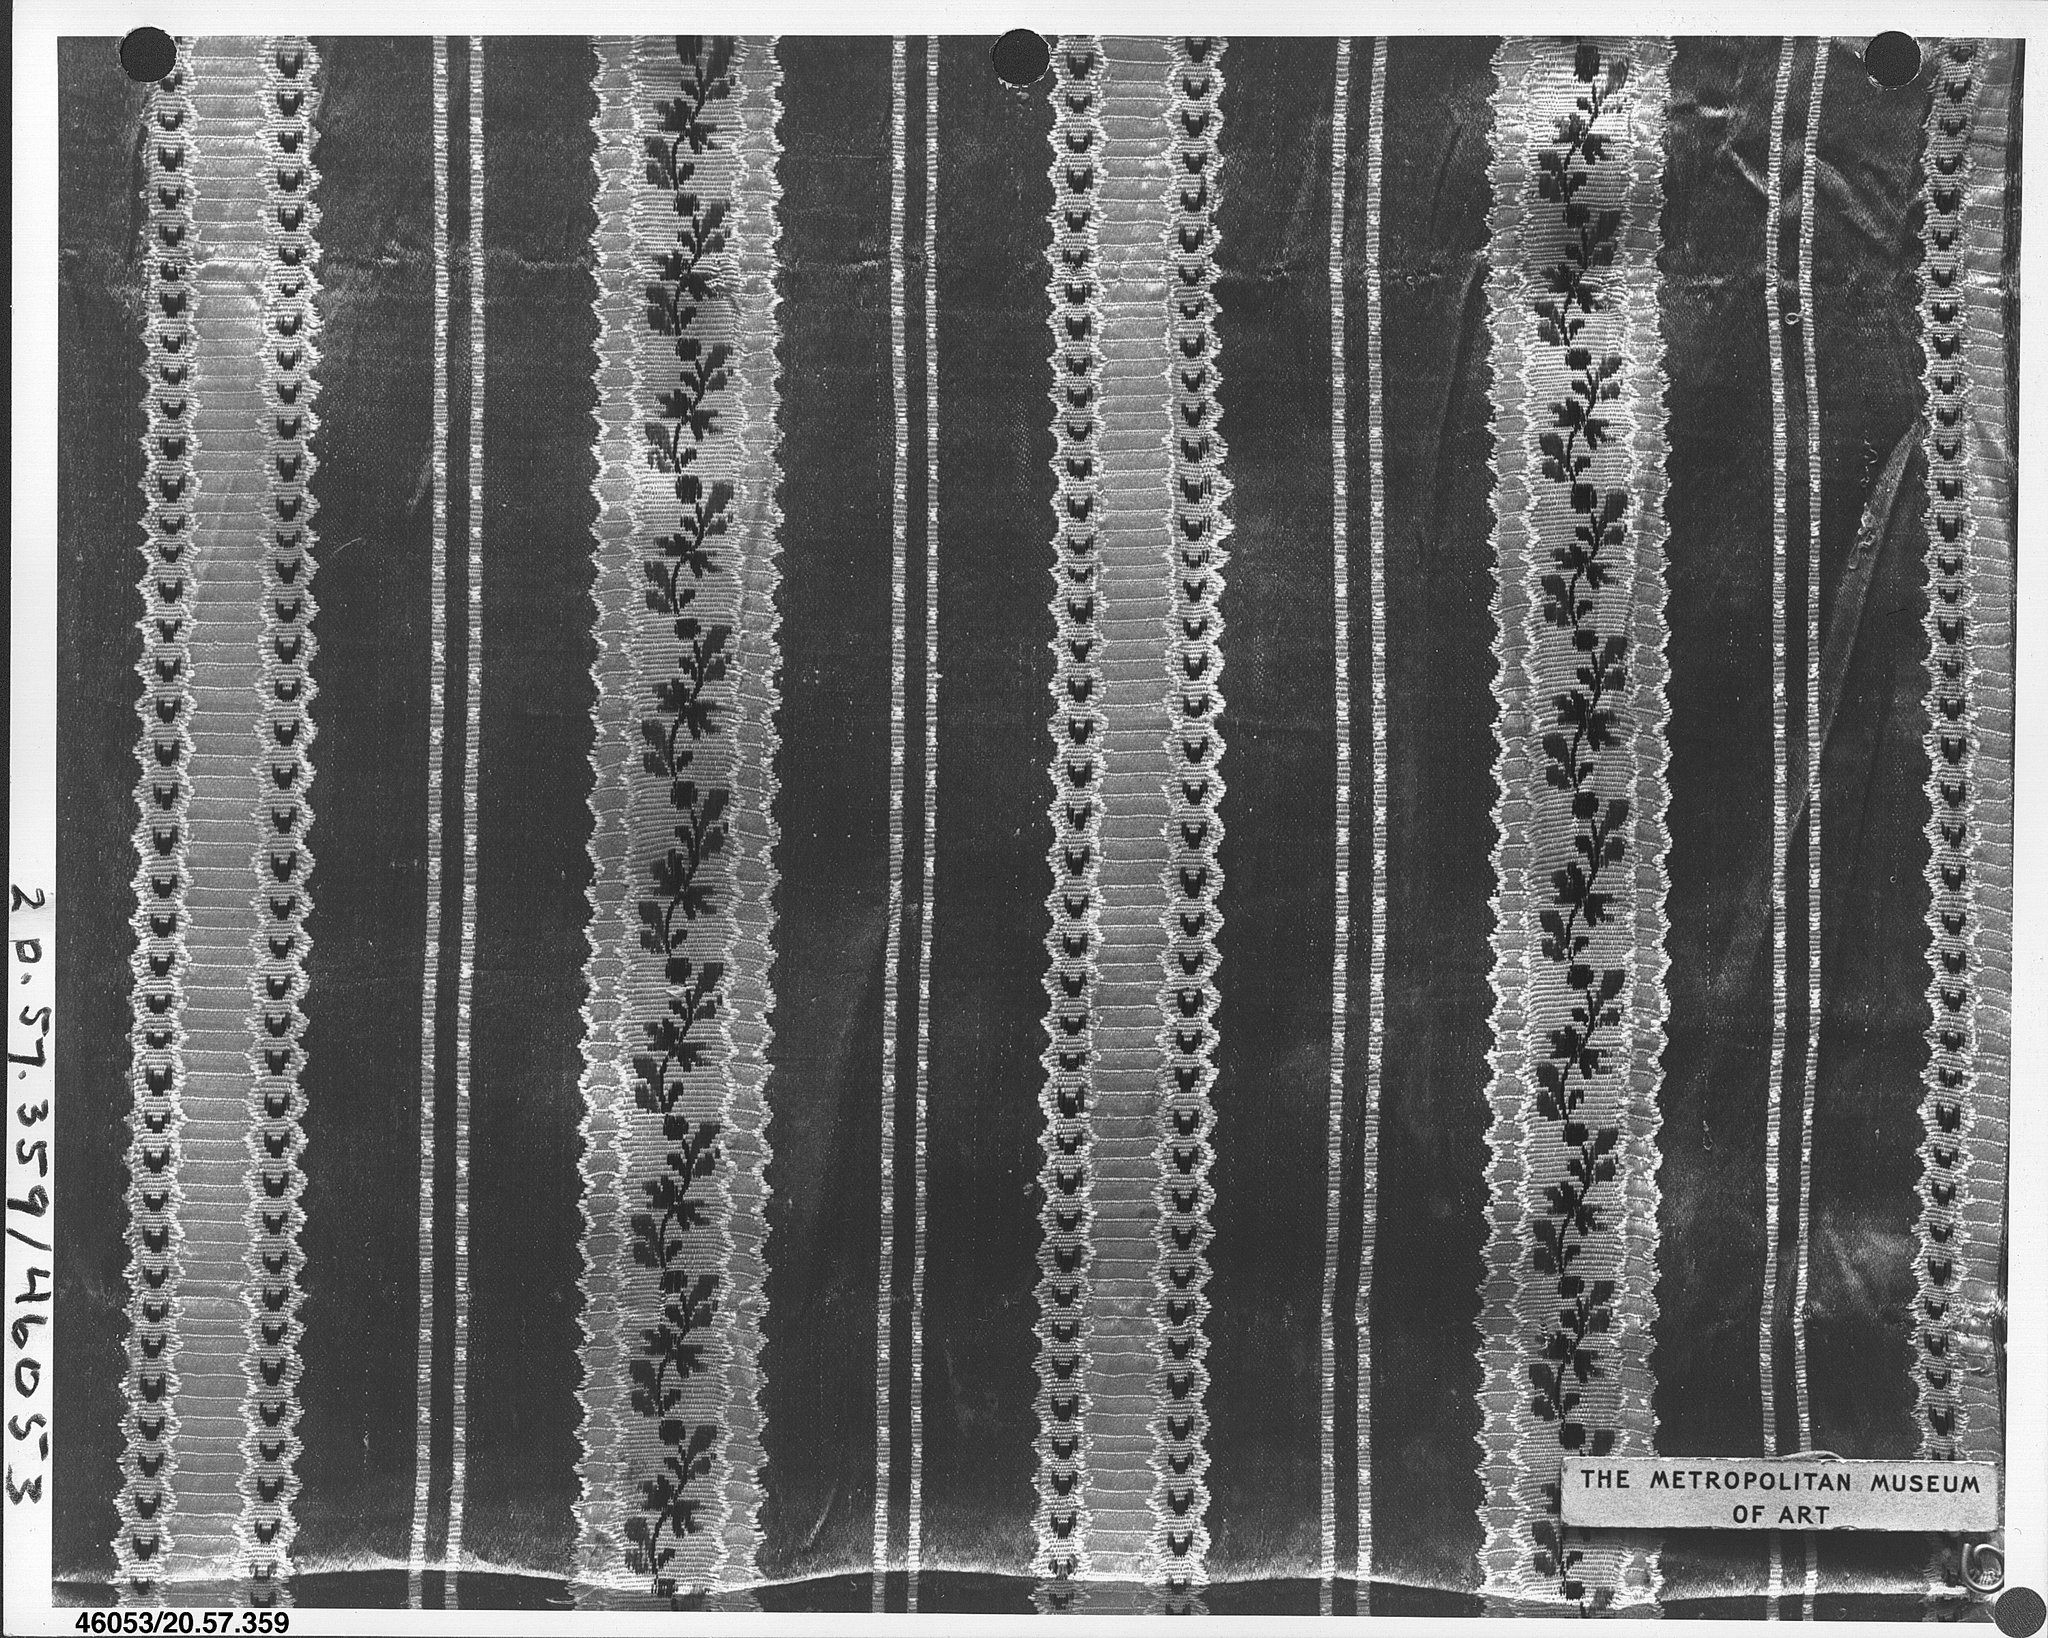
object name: piece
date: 1775-1800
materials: silk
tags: leaves